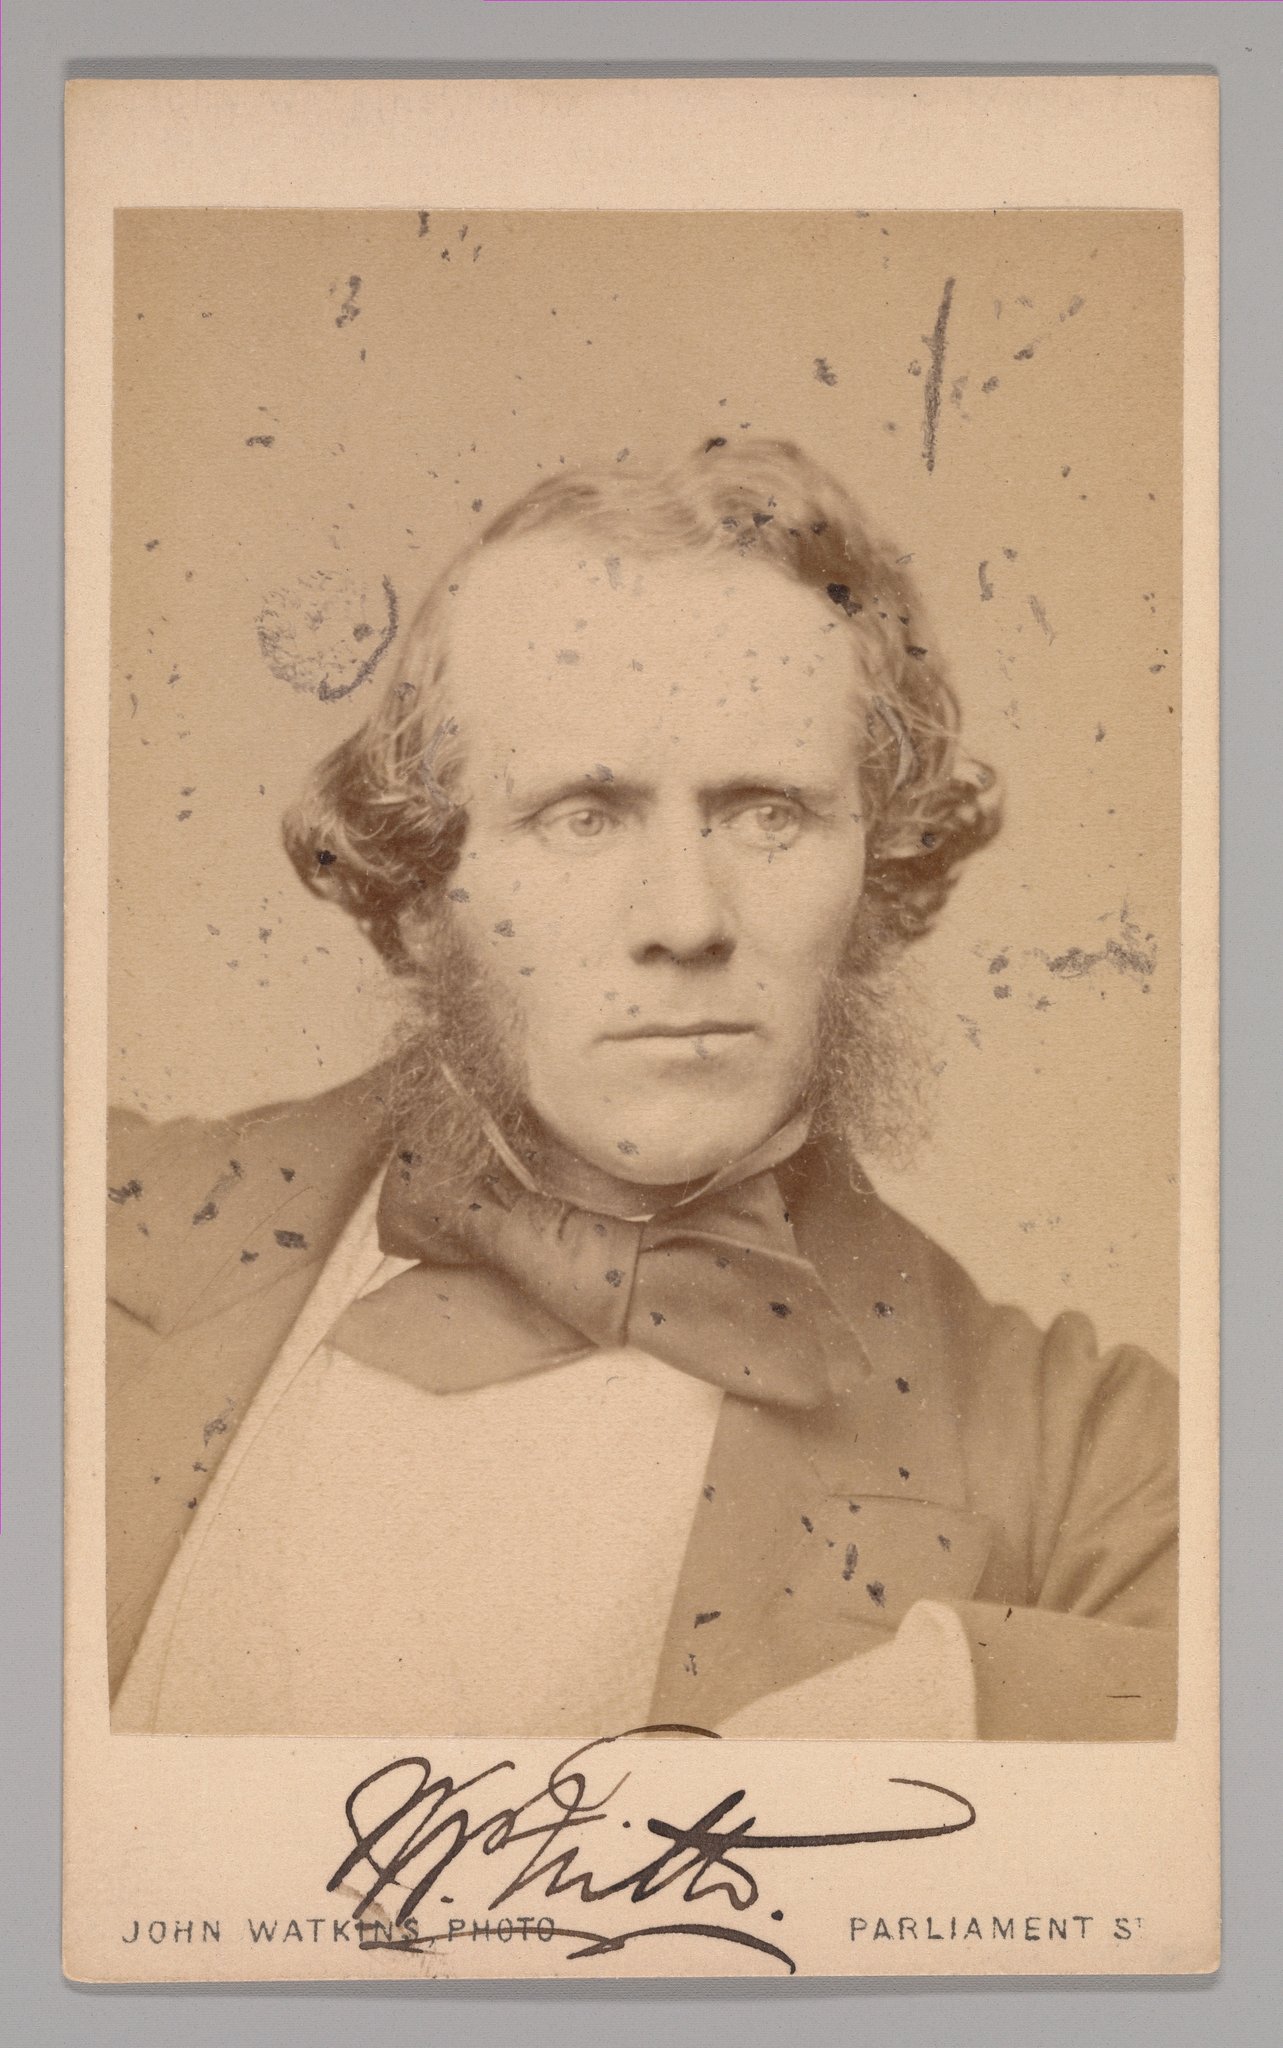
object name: carte de visite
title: [William Powell Frith]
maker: john and charles watkins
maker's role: photography studio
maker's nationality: british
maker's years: 1840-1875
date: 1860-1869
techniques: albumen silver print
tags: men,portraits